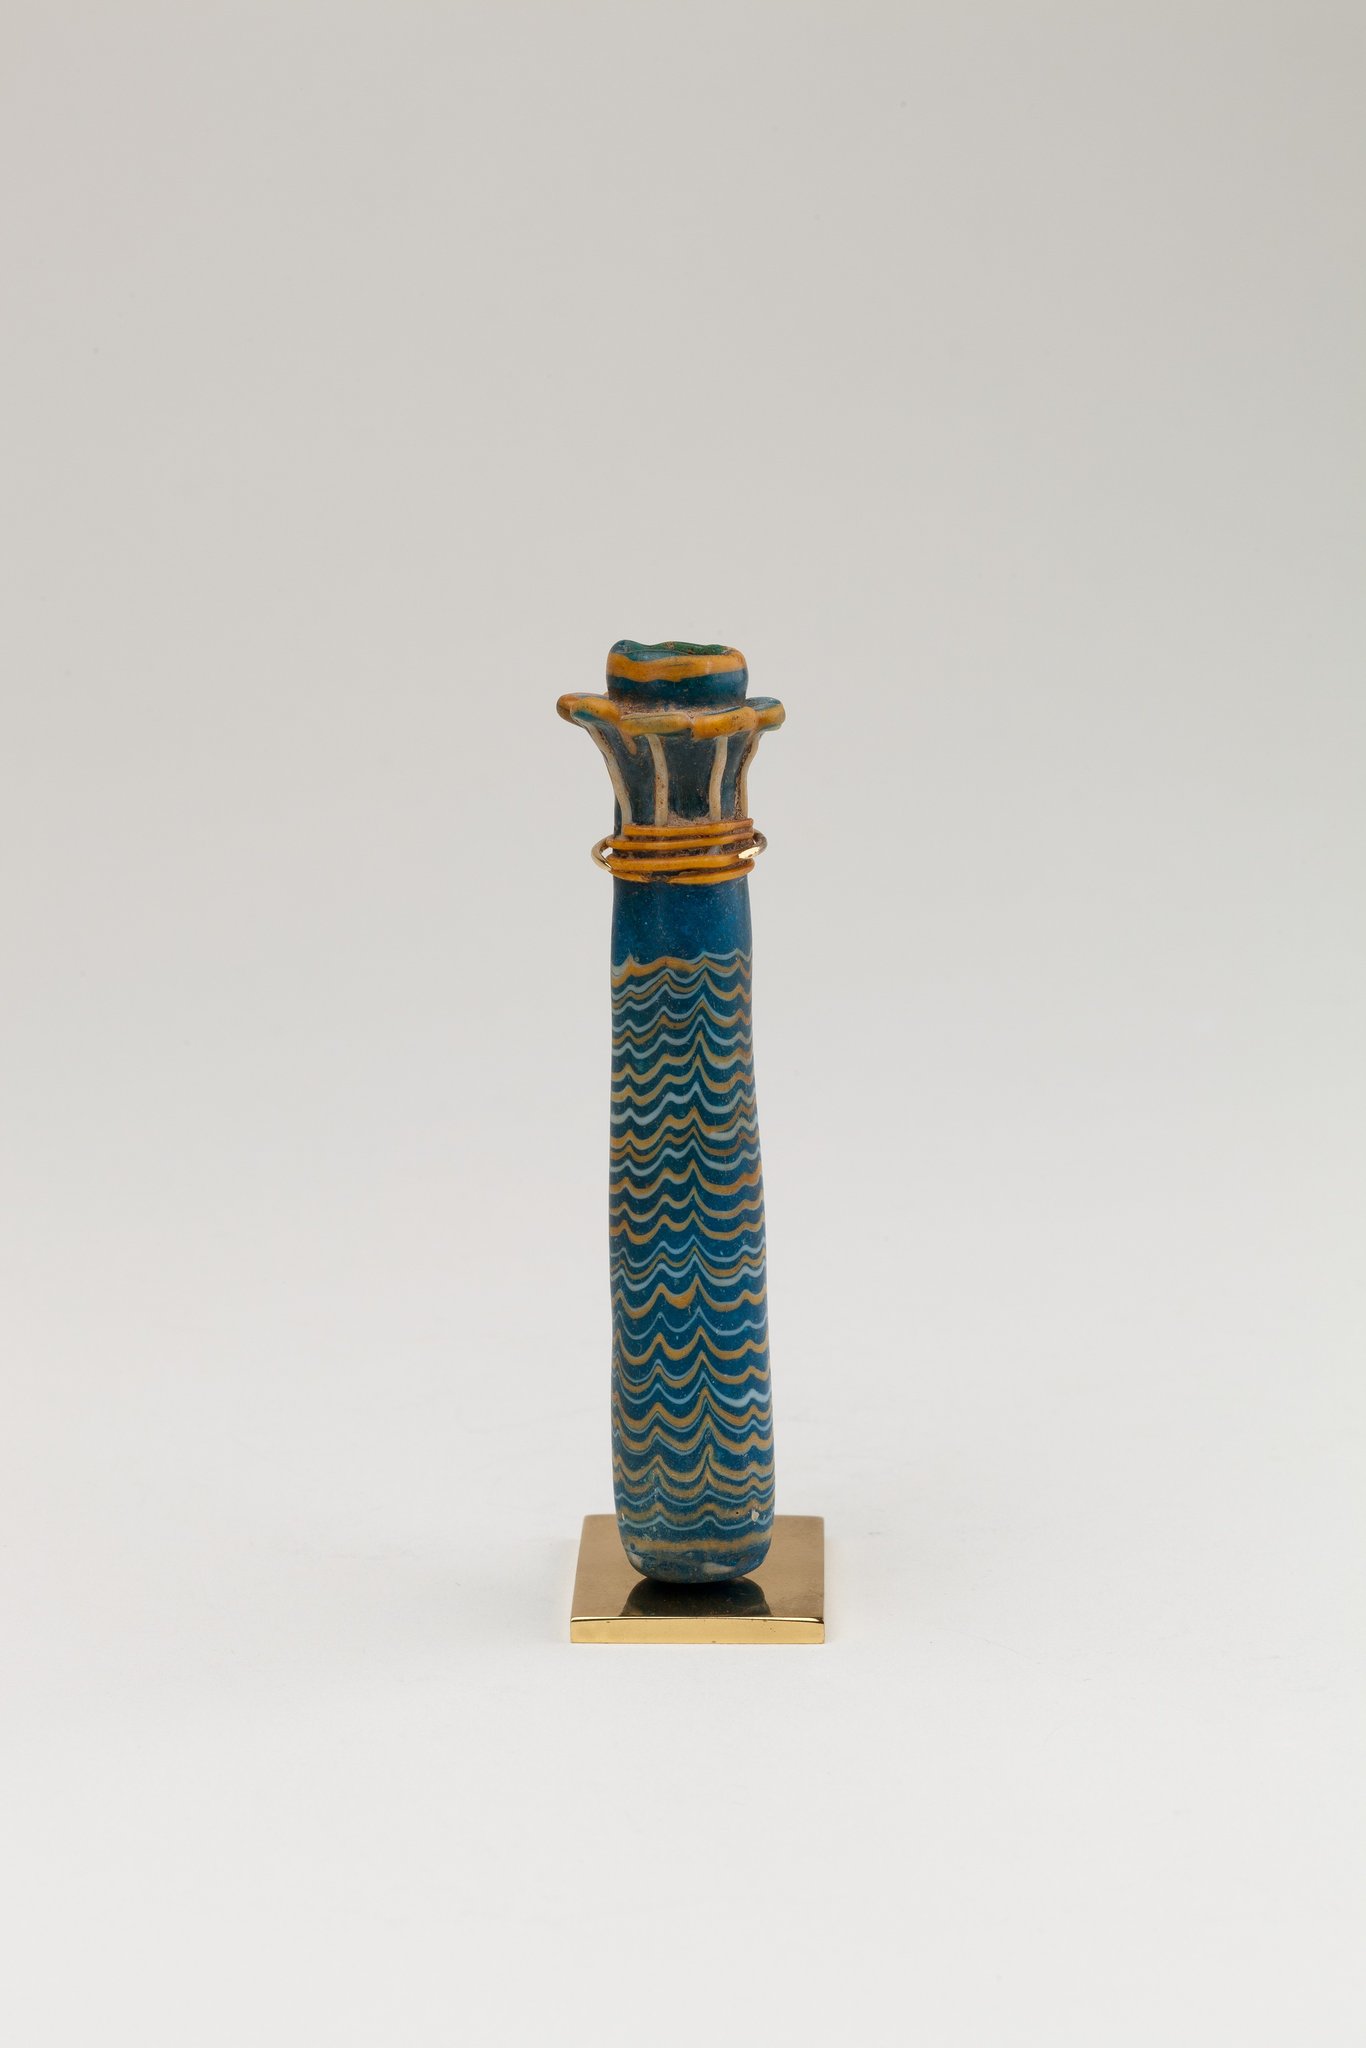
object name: kohl tube, palm column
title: Kohl Tube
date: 1295-1070 BCE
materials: glass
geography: egypt